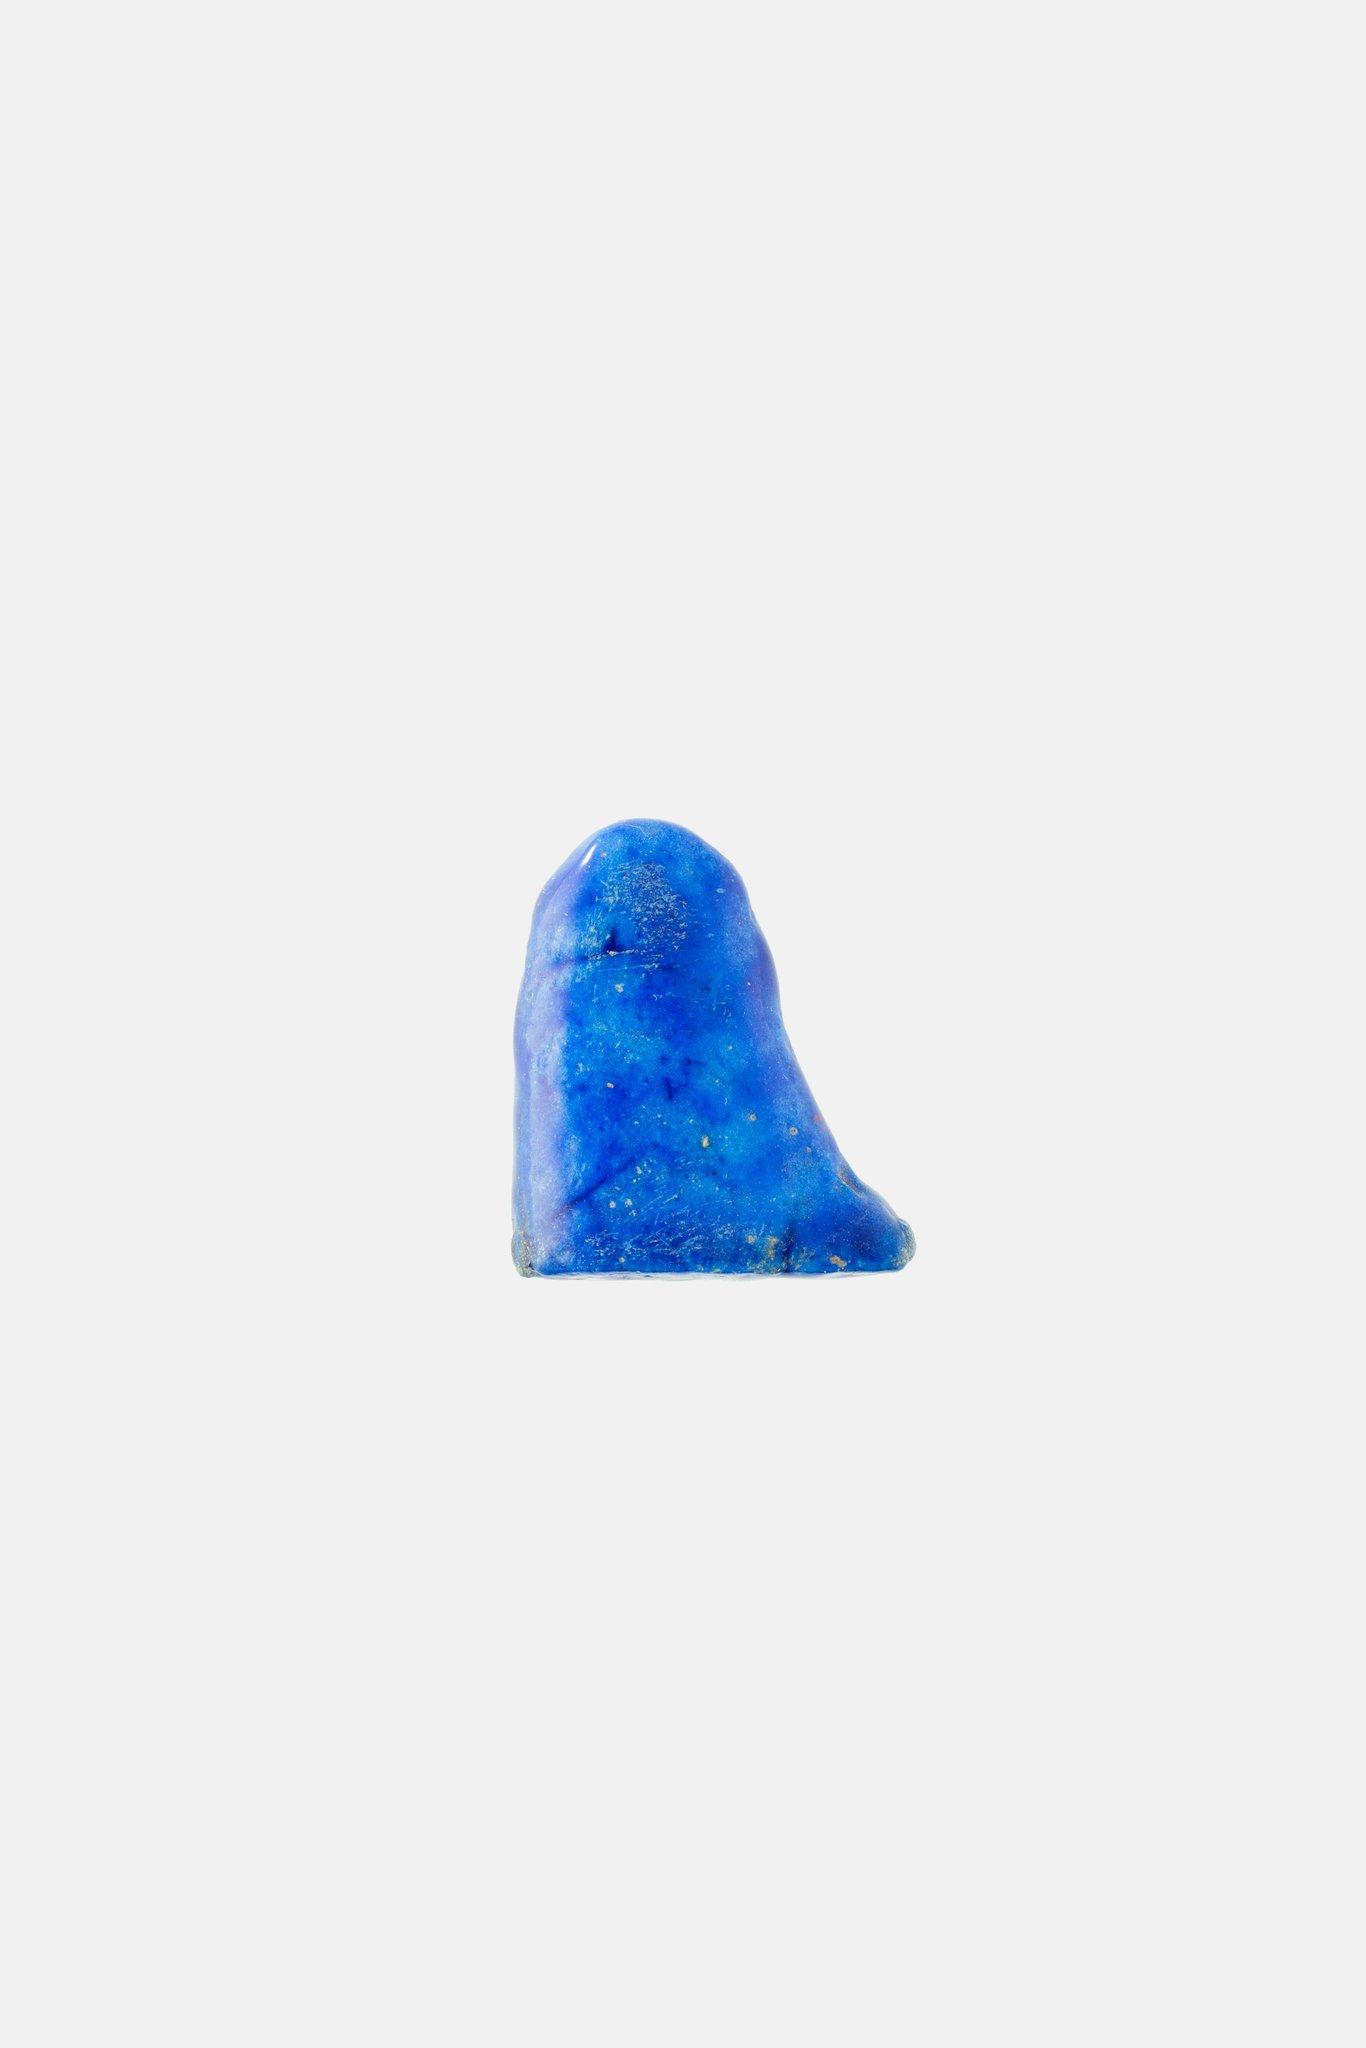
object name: inlay, hieroglyph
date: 664-610 BCE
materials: faience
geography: egypt